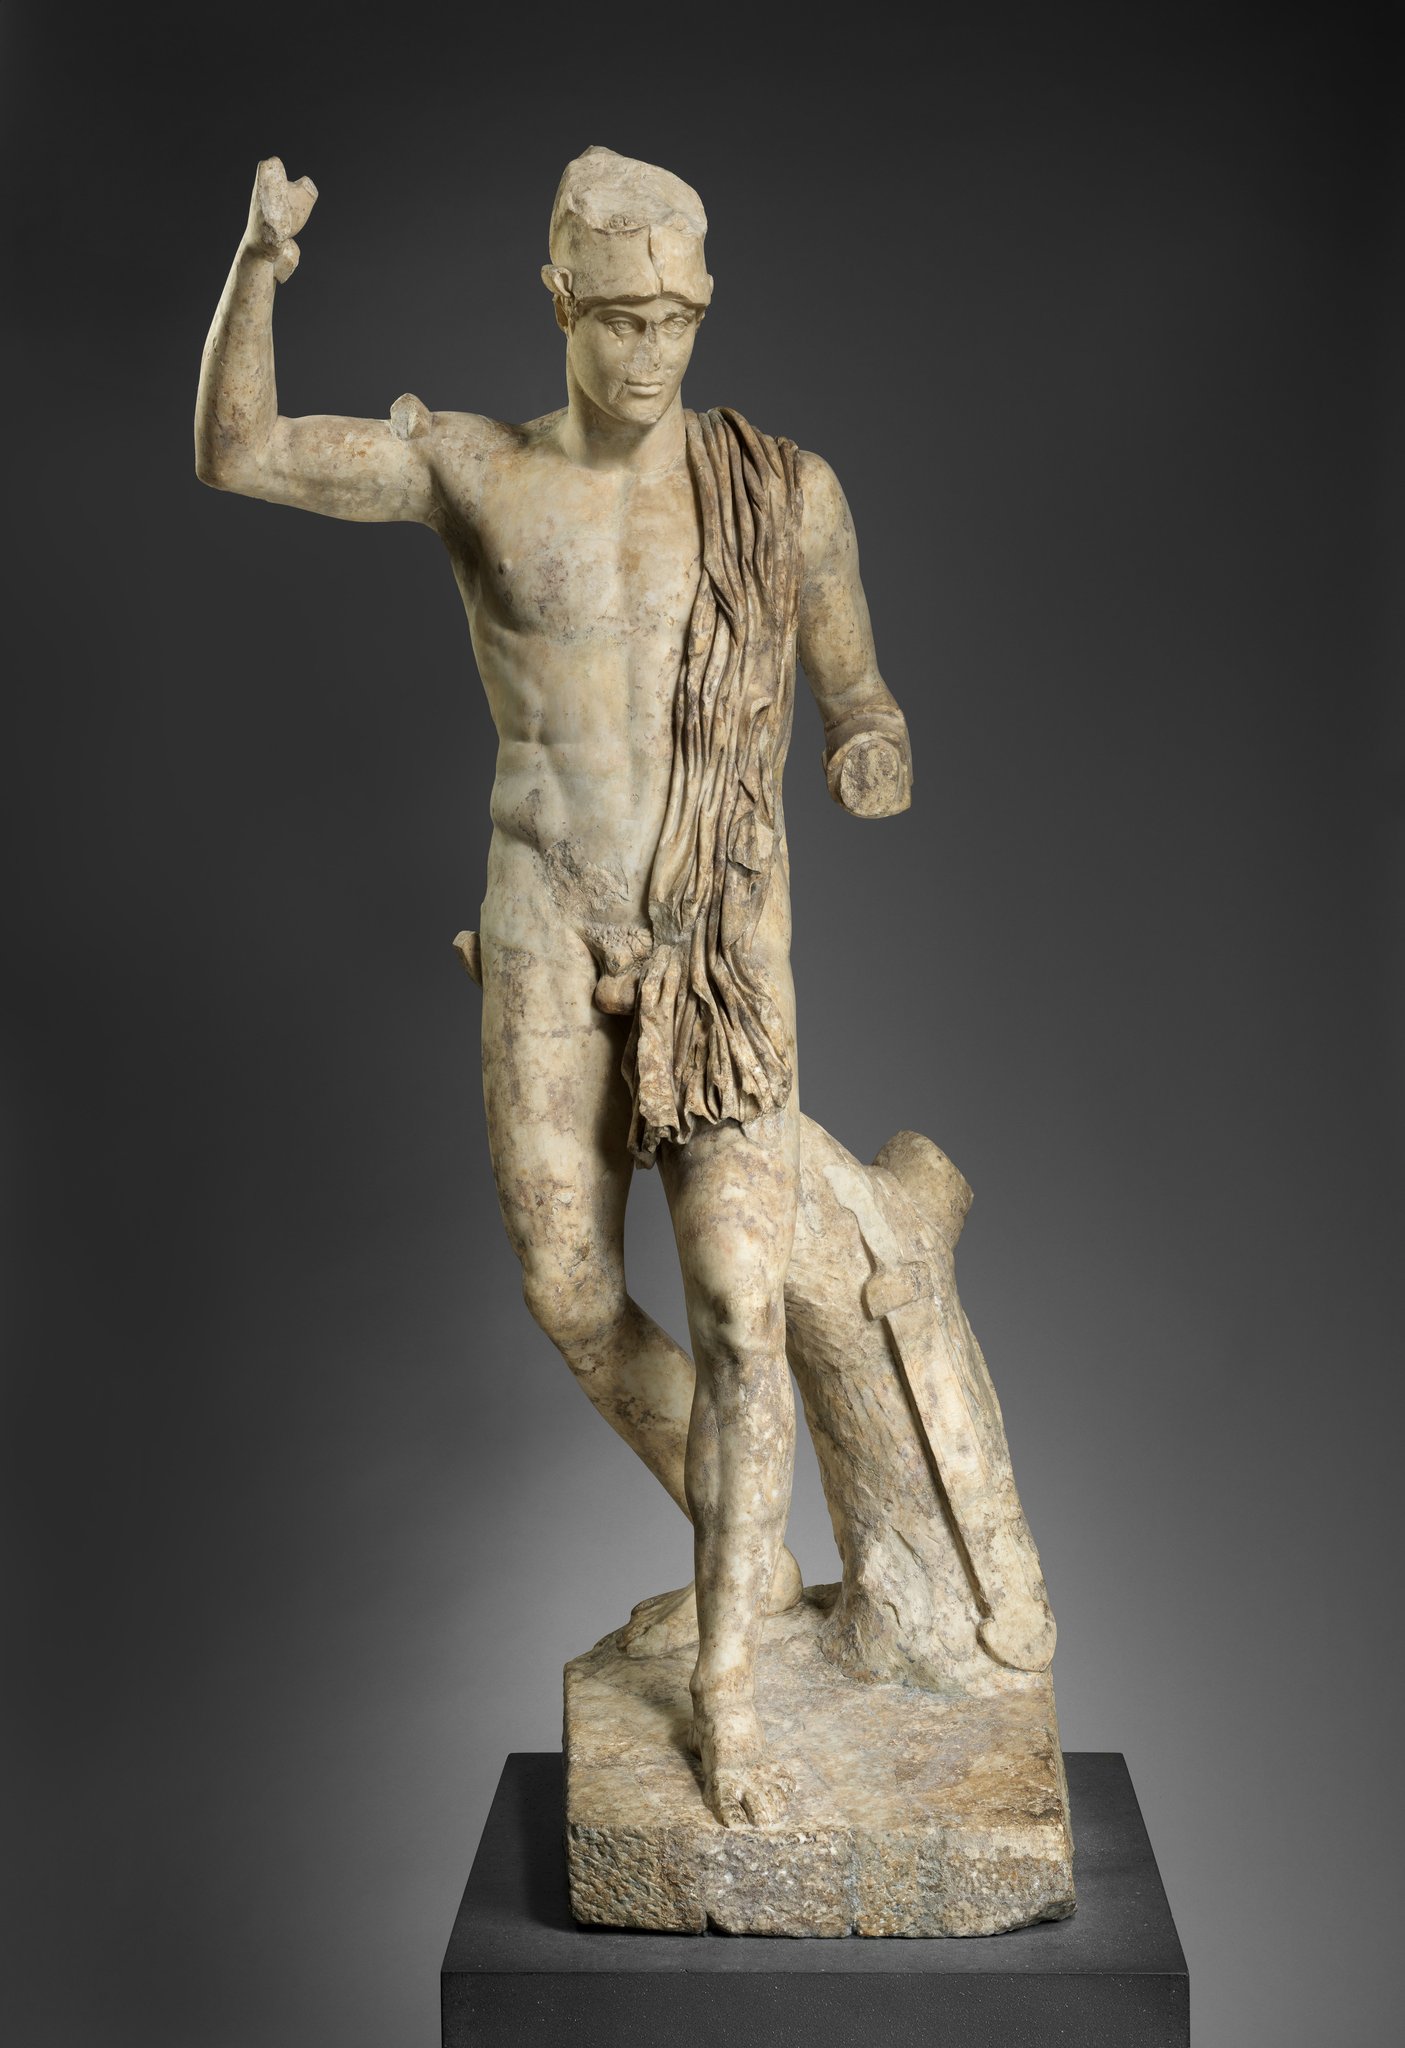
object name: statue of a wounded warrior, protesilaos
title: Marble statue of a wounded warrior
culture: roman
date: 138-181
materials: marble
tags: male nudes